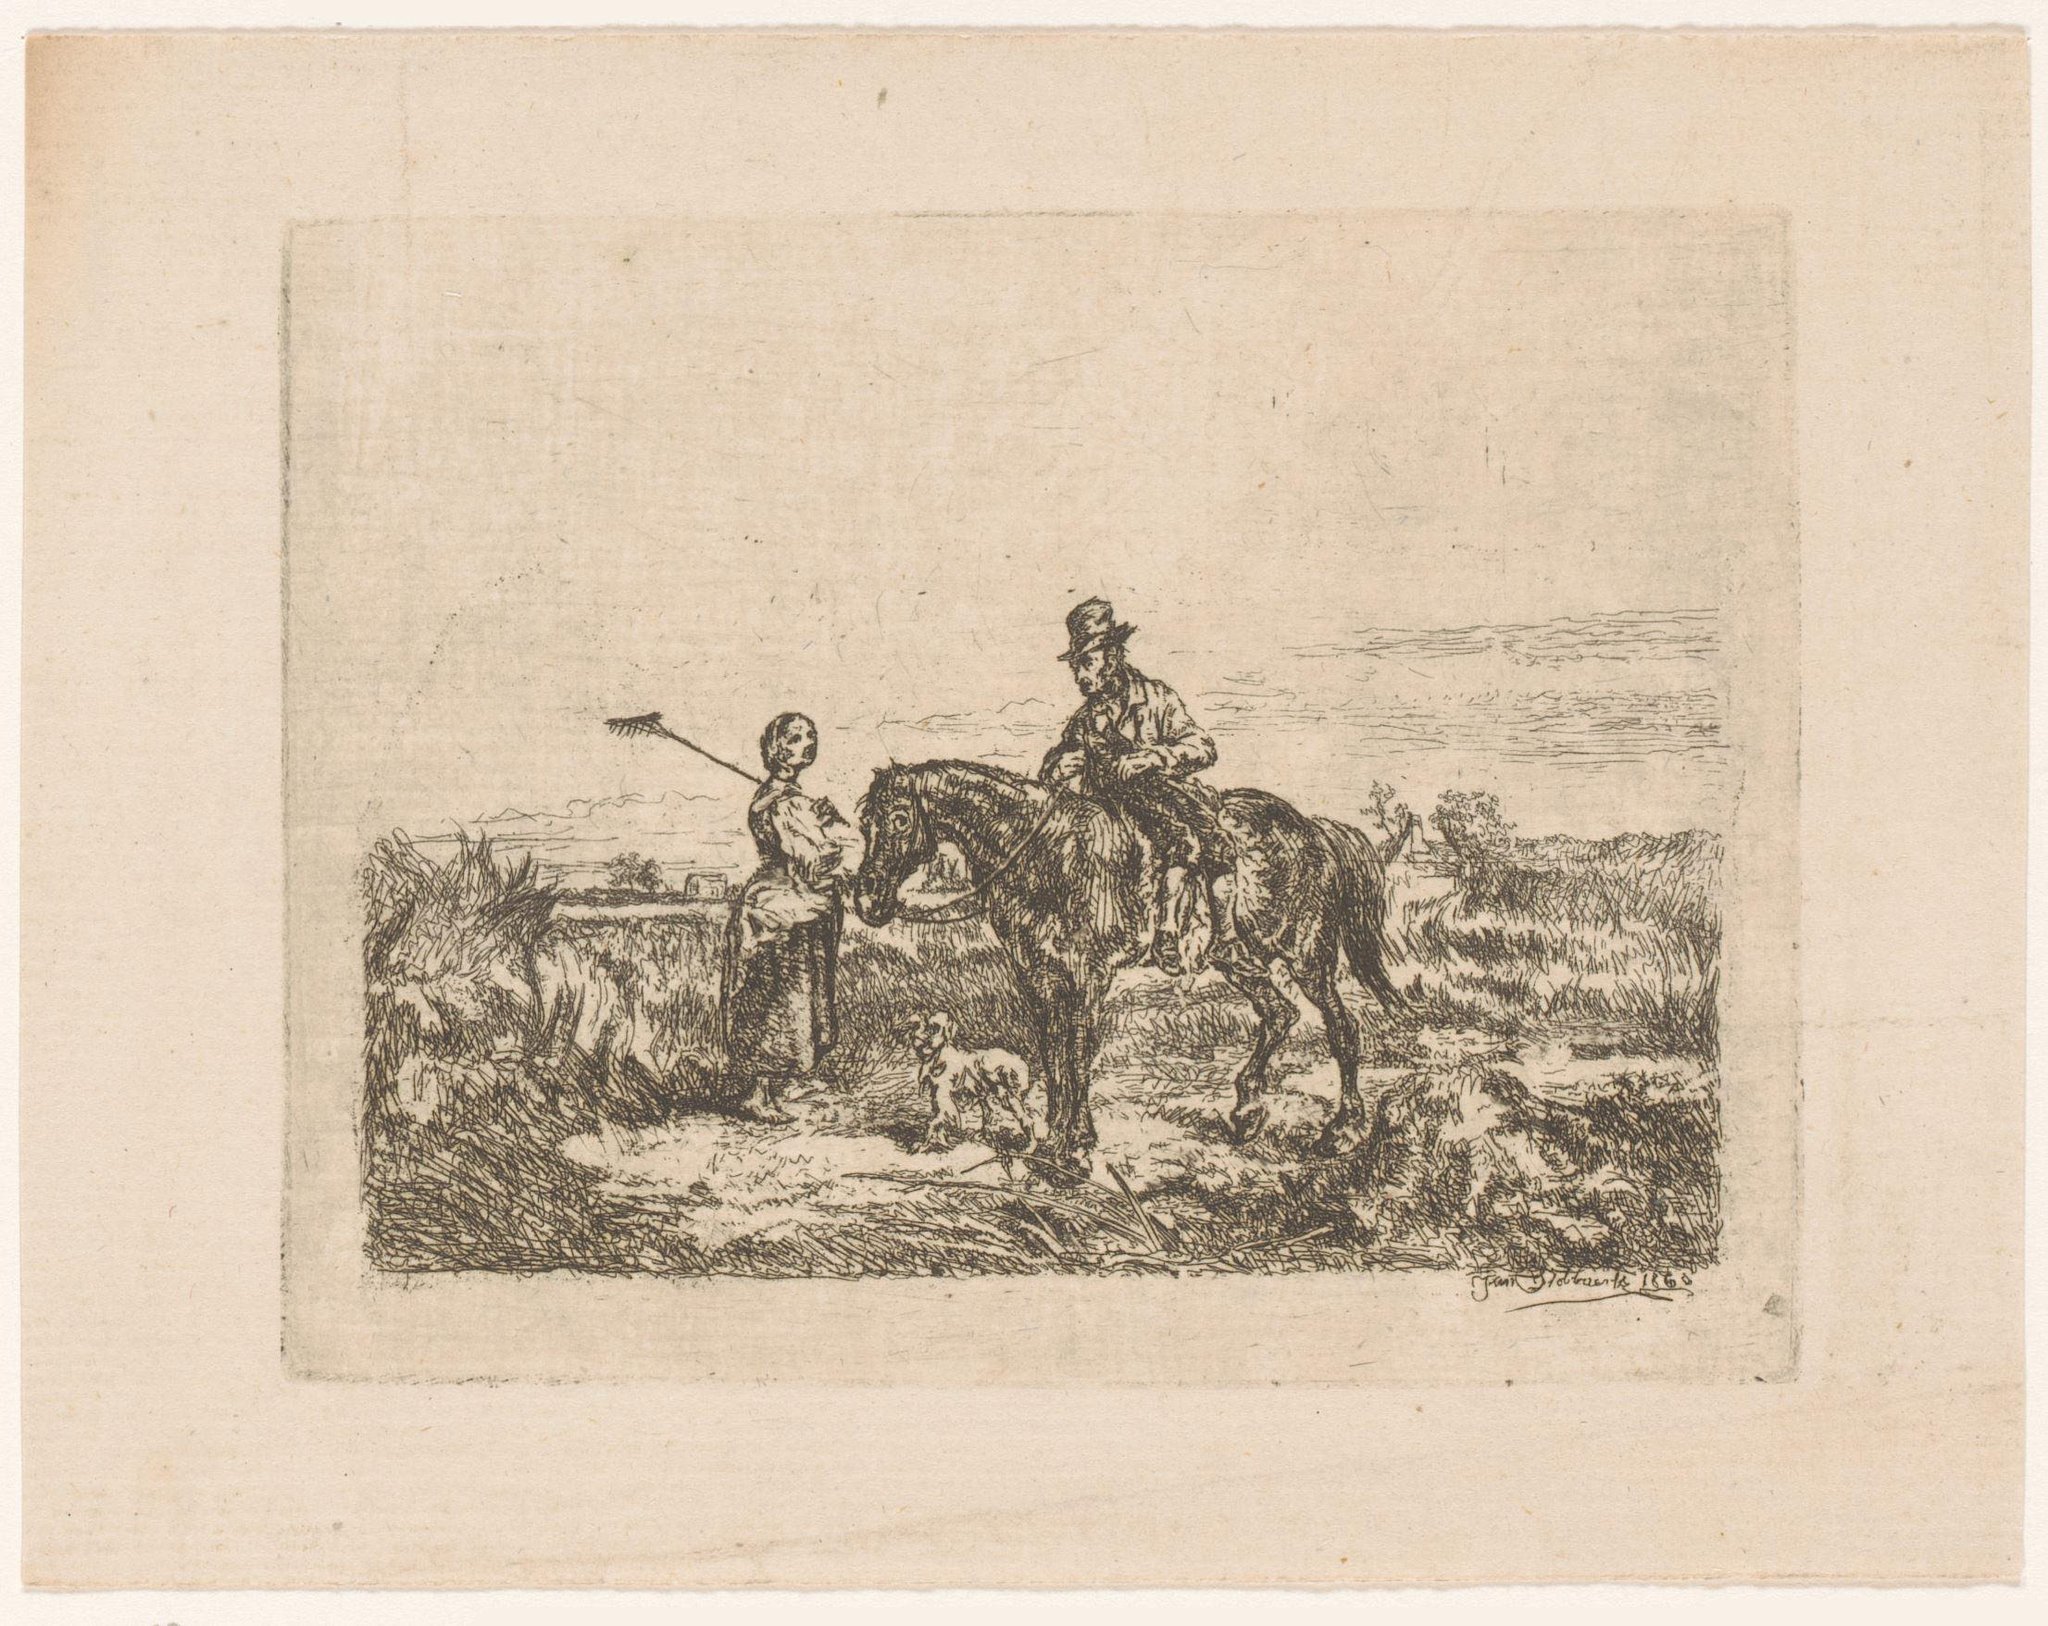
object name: print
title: Landschap met man te paard en vrouw met hark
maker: jan stobbaerts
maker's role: draughtsman, print maker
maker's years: 1838-1914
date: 1860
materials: paper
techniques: etching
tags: riding a horse, ass, or mule; rider, horseman, landscapes (+ landscape with figures, staffage), agricultural implements: rake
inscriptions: collector's mark: Lugt 2228